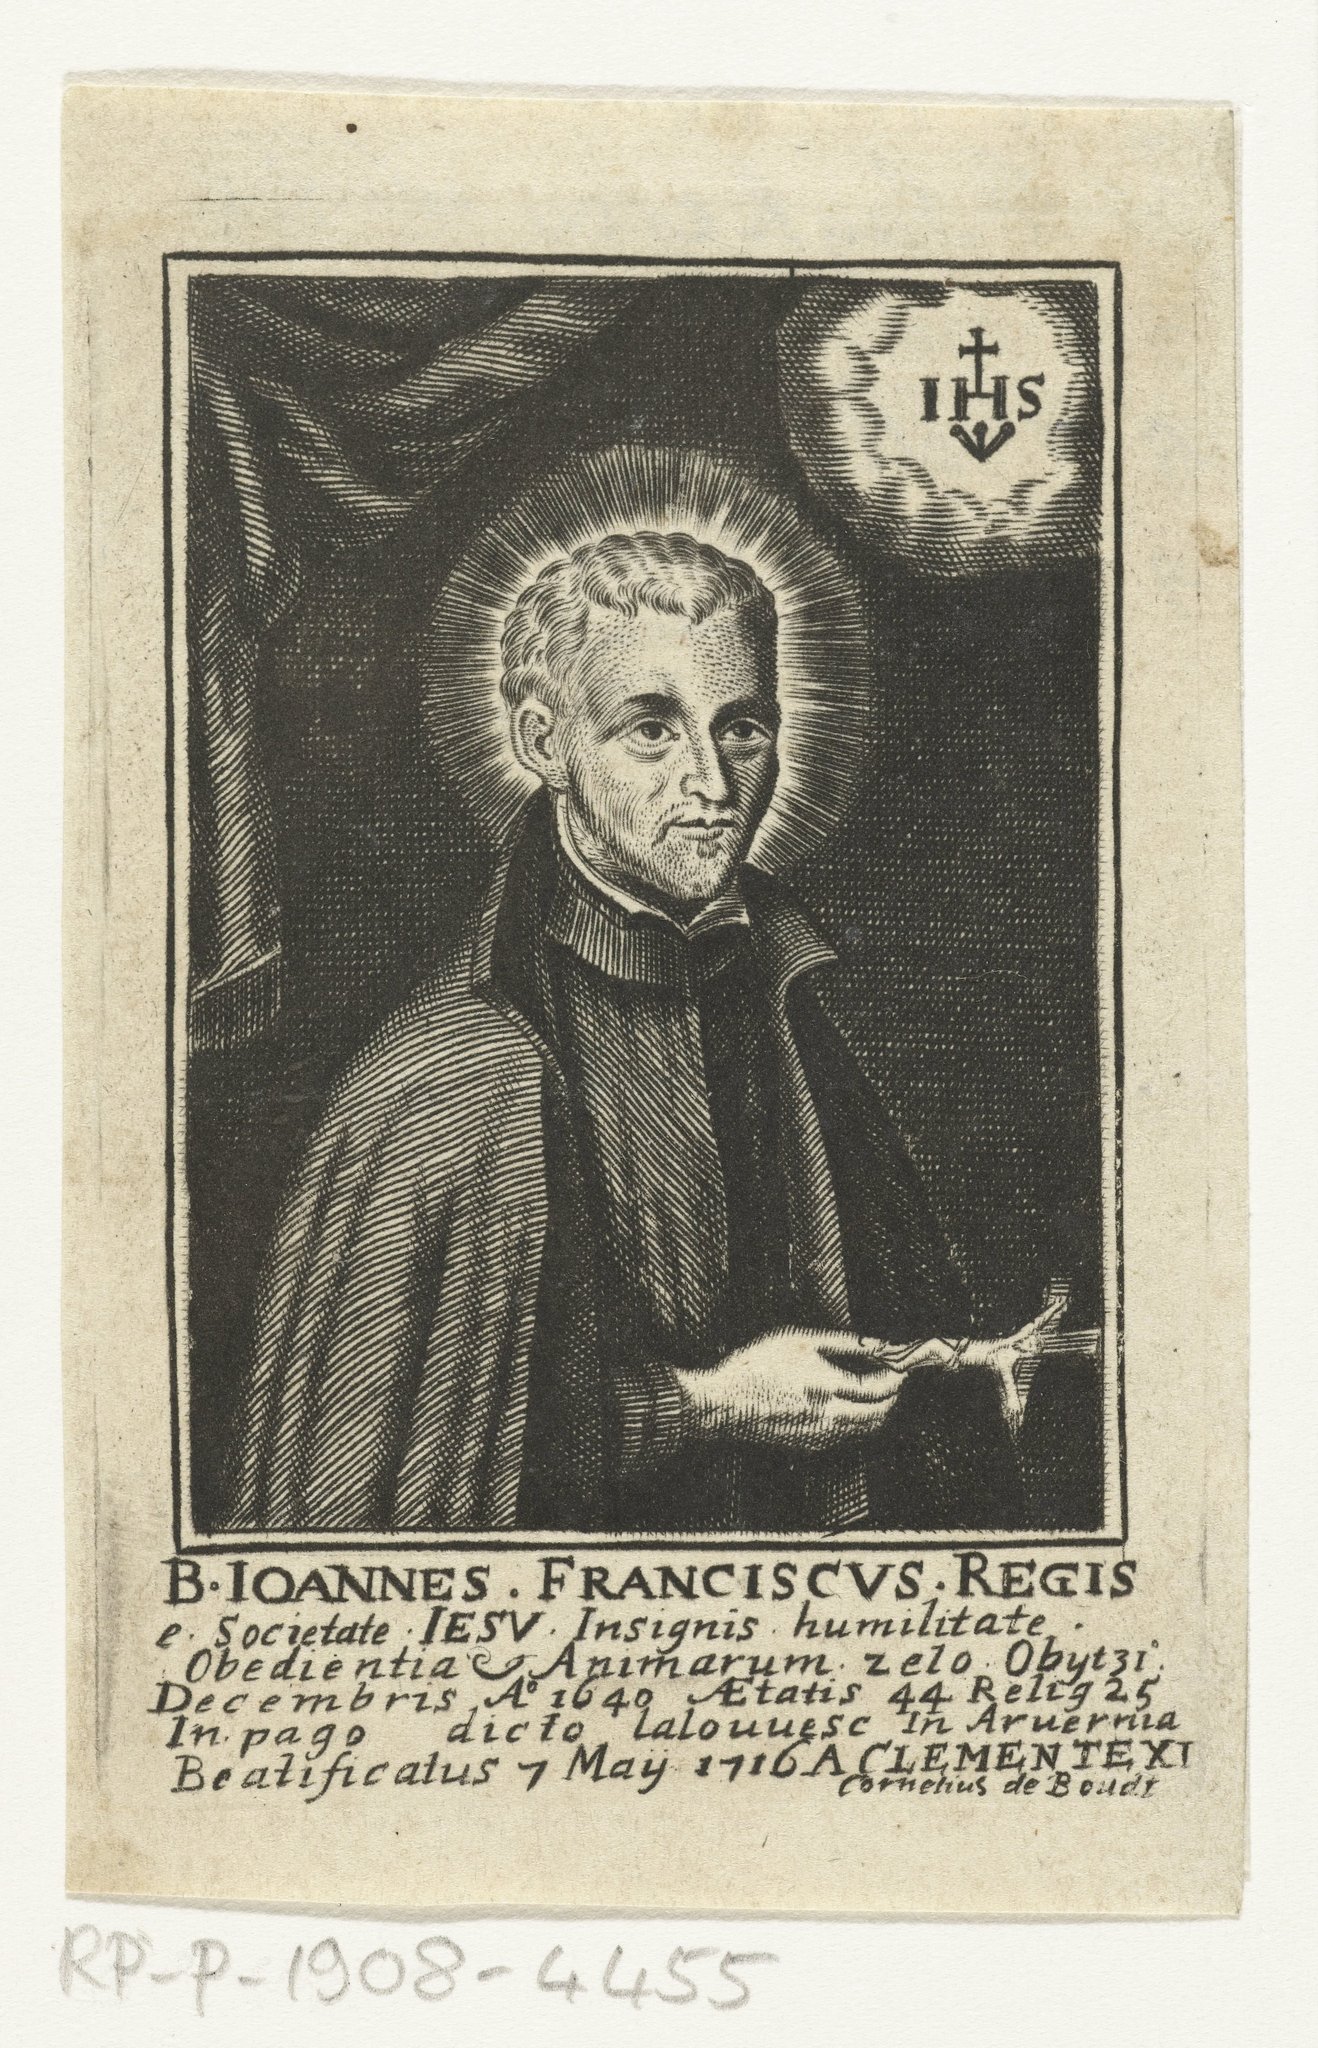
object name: print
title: Bidprent met de heilige Johannes Franciscus Régis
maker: cornelis de bout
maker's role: print maker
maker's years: 1660-1735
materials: paper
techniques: engraving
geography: antwerp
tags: regular clerics, e.g. jesuits, redemptorists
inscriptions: inscription: ‘1/4 [...] suykerey wortel / 5 [...] somerknol / 5 [...] veltslae / 1/4 [...] posteleyn’, collector's mark: Lugt 2228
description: Bidprent voor de heilige Johannes Franciscus Régis, Jezuiet en volksprediger. Johannes Franciscus Régis draagt het habijt van de Jezuïeten en houdt een crucifix in zijn hand. Rechts in de hoek het symbool van de Jezuïetenorde.